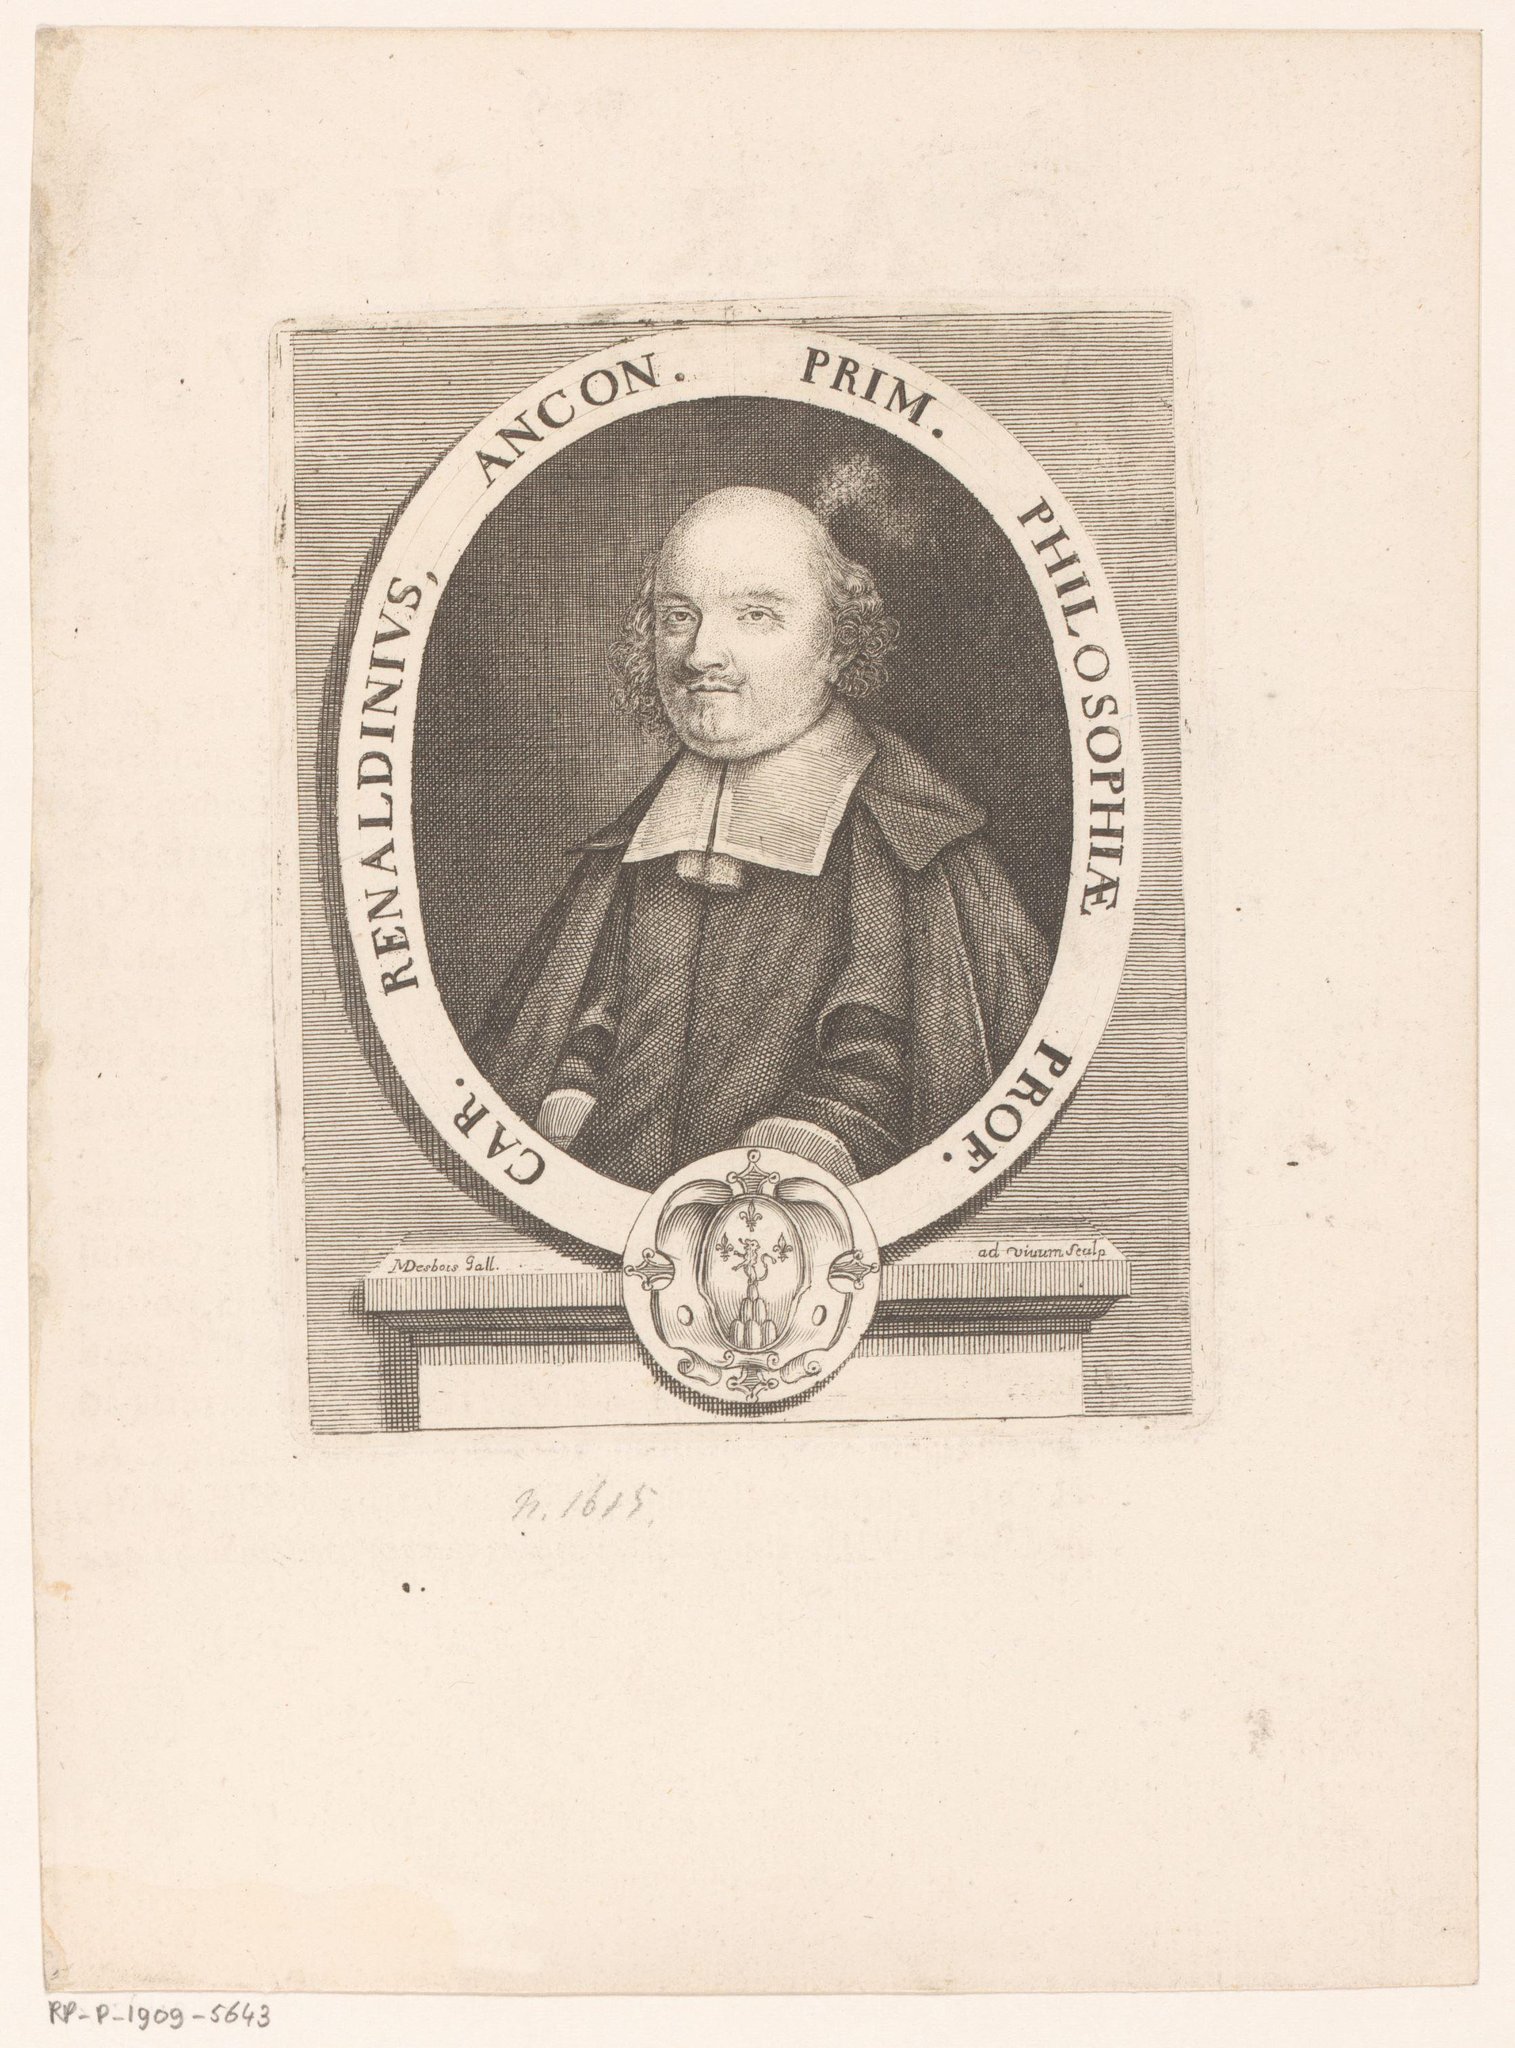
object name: book illustration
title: Portret van Carlo Renaldini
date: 1682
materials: paper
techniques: engraving, etching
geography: padua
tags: historical persons, professor, armorial bearing, heraldry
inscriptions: collector's mark: Lugt 2228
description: Prent uit: Patin, Charles. Lyceum Patavinum: sive icones et vitae professorum. Padua: Frambotti, Petri Mariae, 1682.